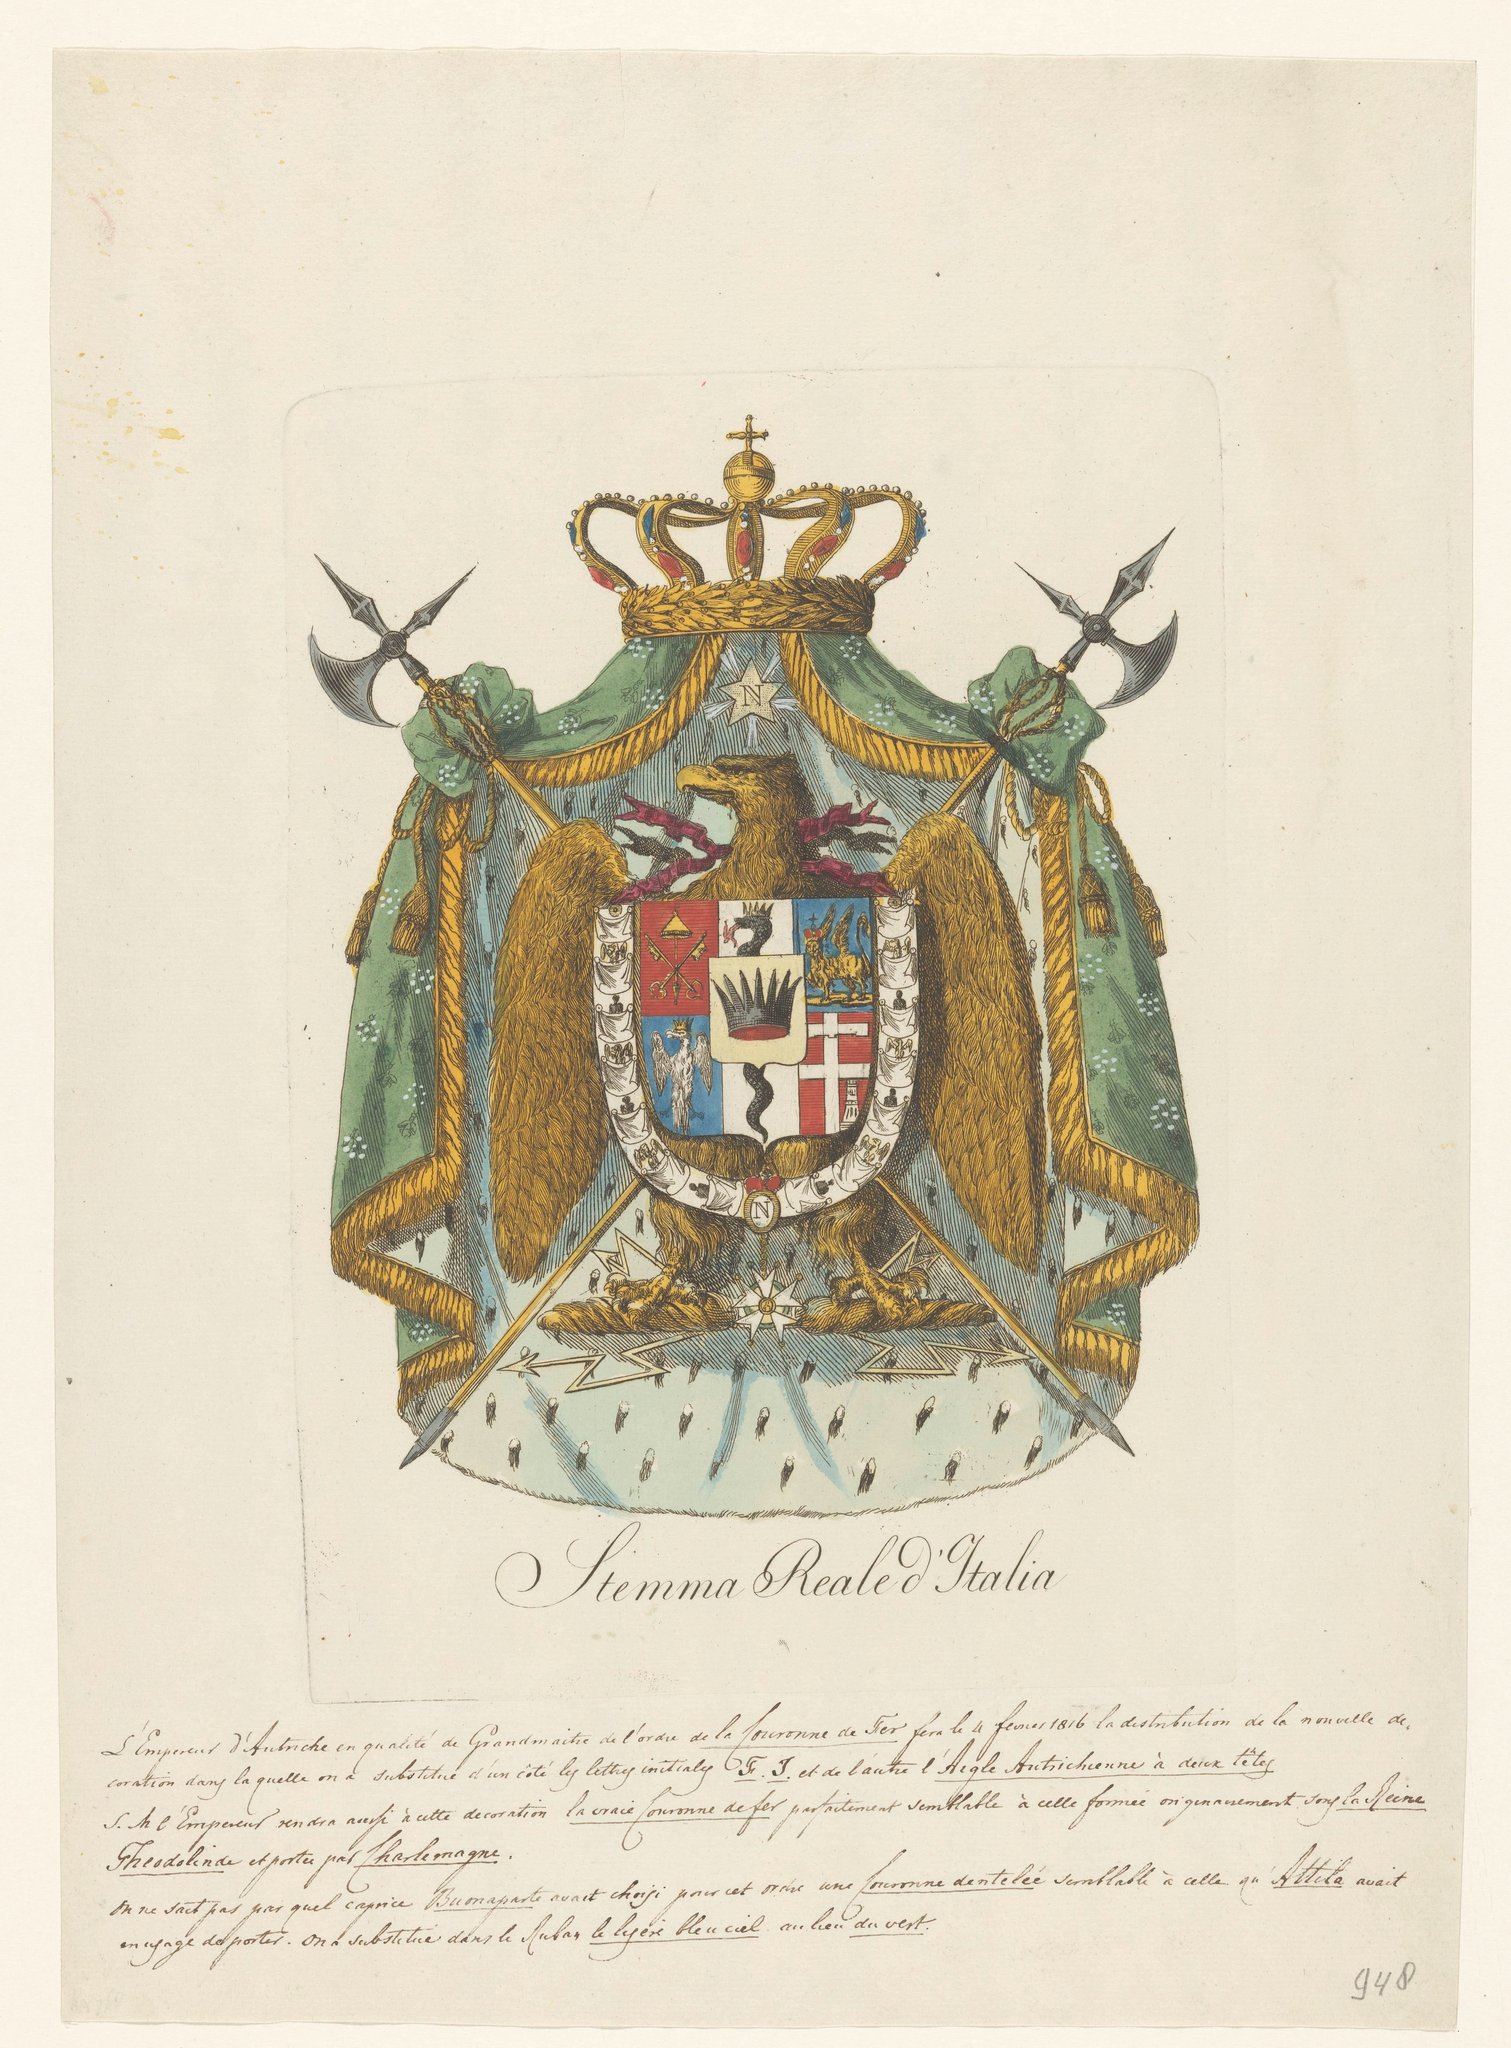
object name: print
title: Stemma Reale d'Italia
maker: Anonymous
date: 1805-1850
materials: paper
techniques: etching, hand coloring, pen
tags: napoleon i (emperor of the french), coat of arms (as symbol of the state, etc.), italy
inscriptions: collector's mark: Lugt 2228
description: Wapen van het Koninkrijk Italië (1805-1814), een Noord-Italiaanse vazalstaat van Frankrijk met Napoleon als koning . Met annotatie in de marge in het Frans over de totstandkoming van dit wapen.